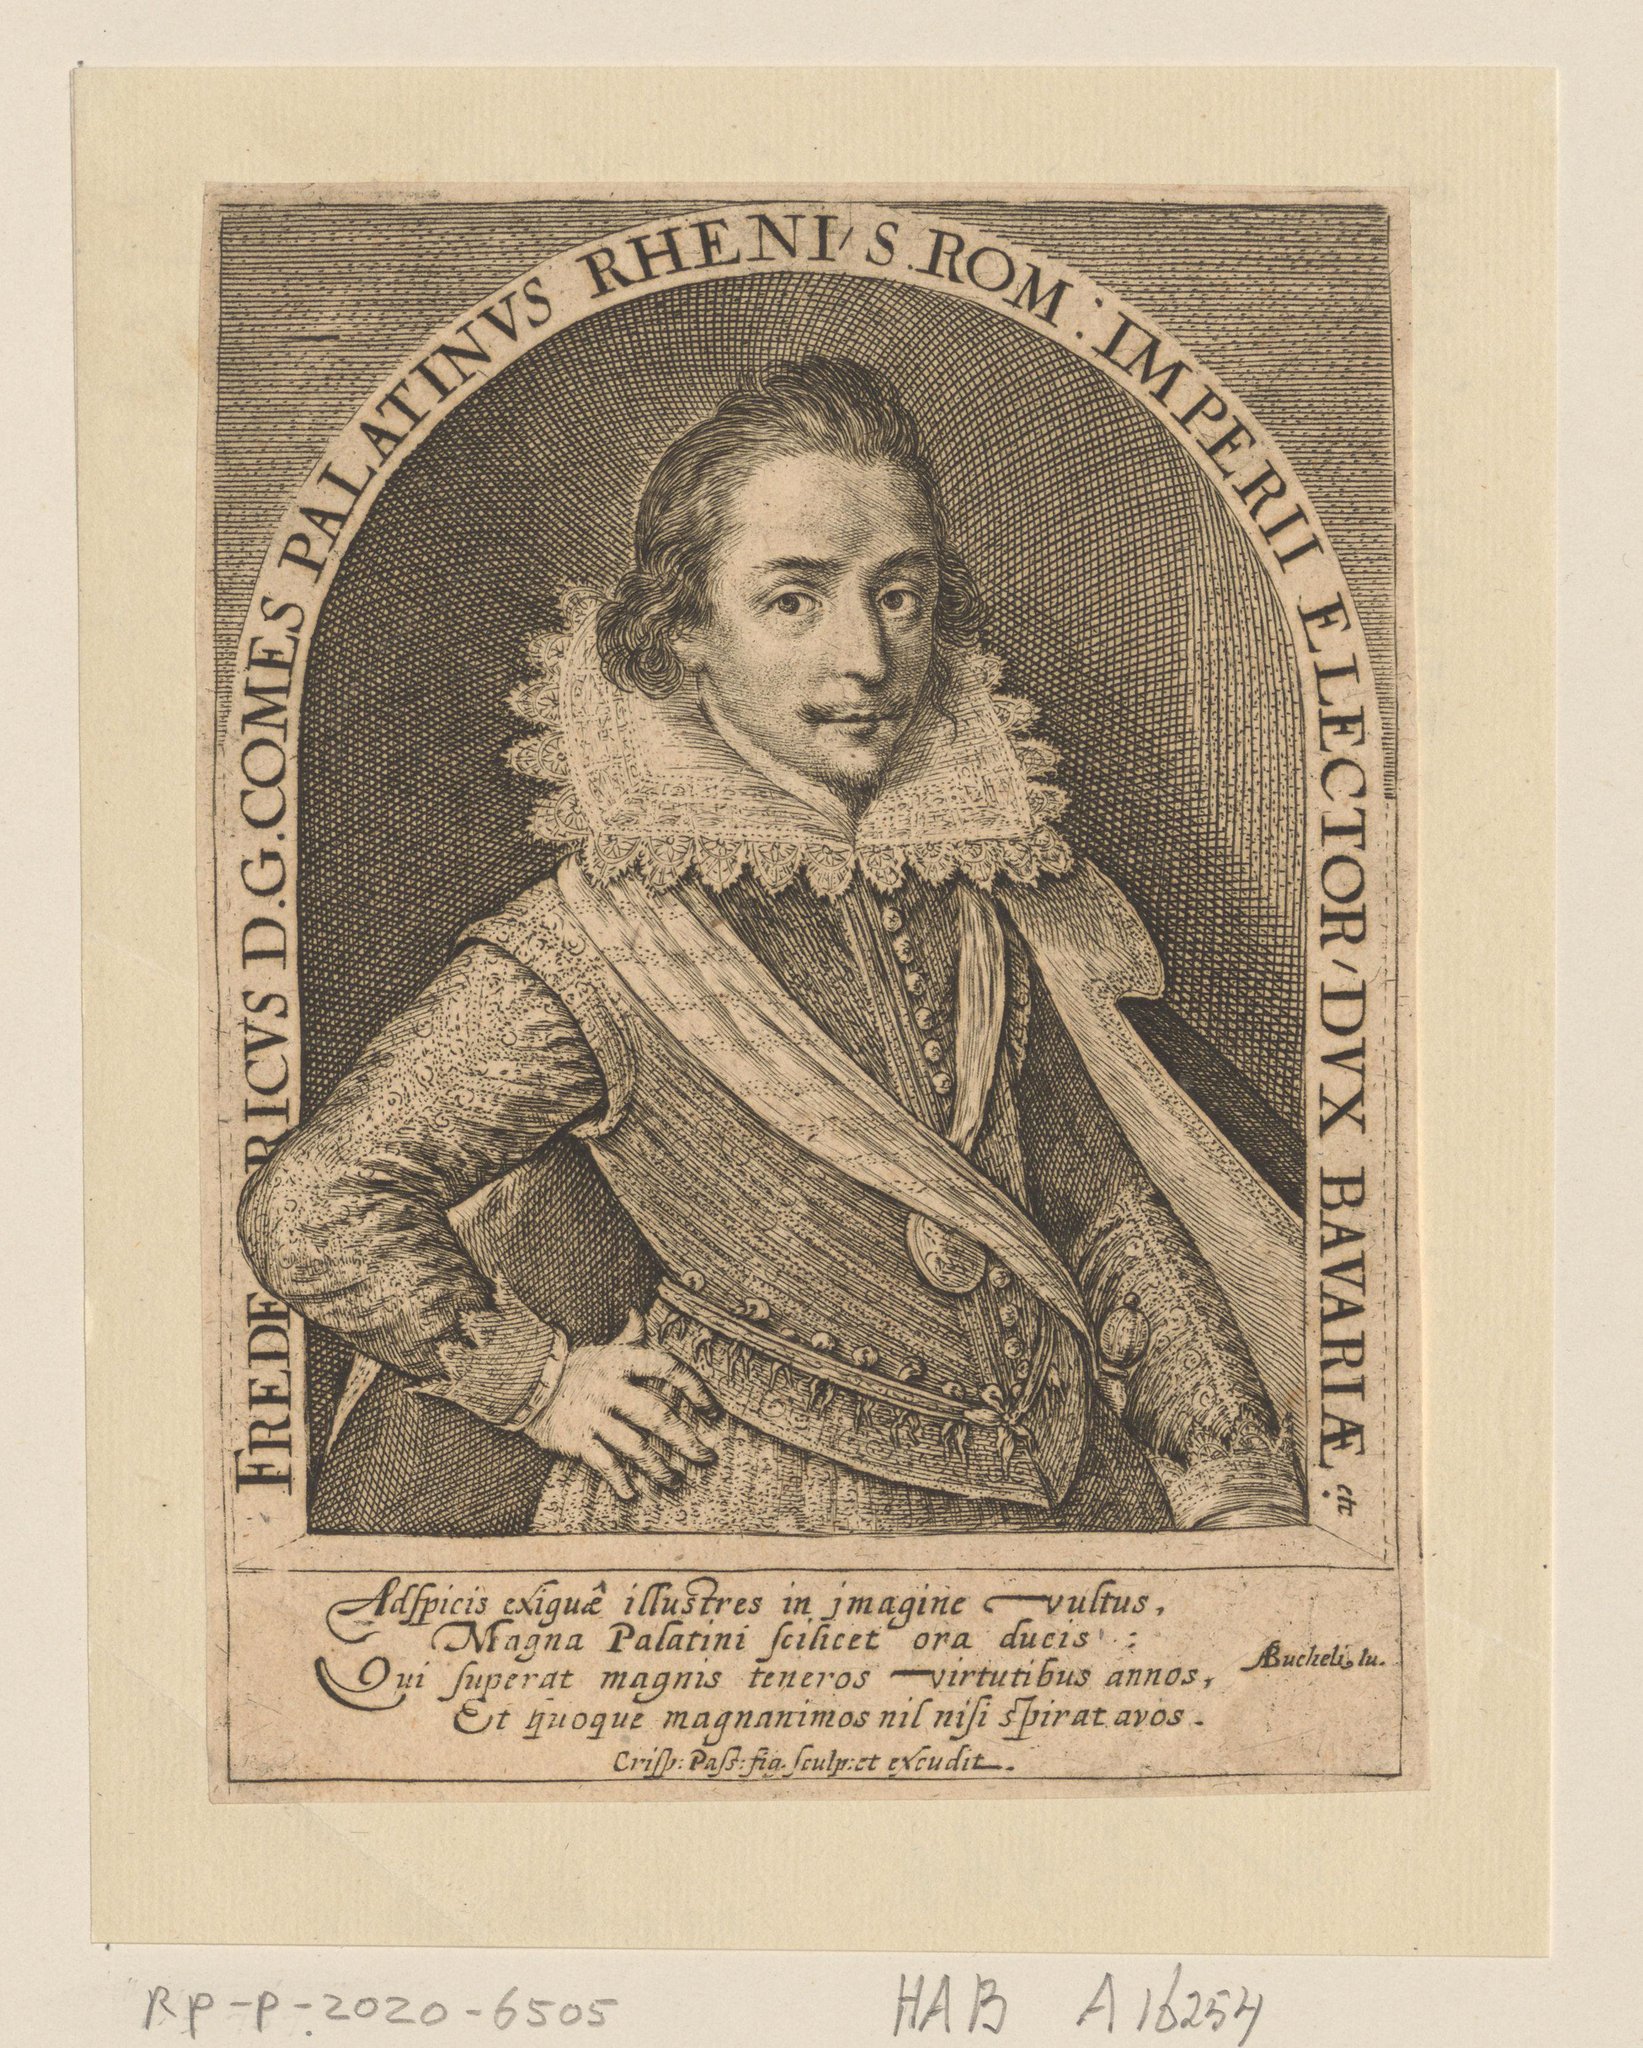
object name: print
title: Portret van Frederik V van de Palts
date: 1613-1637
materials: paper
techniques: engraving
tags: frederik v (keurvorst van de palts, koning van bohemen), historical persons, ruler, sovereign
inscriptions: inscription: ‘Frederik V, Zoon van Frederik IV, Keurvorst van/ de Palts, in 1596 te Amberg geboren (...)’, number: ‘No. 464.’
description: Met vierregelig vers in het Latijn onder het portret.